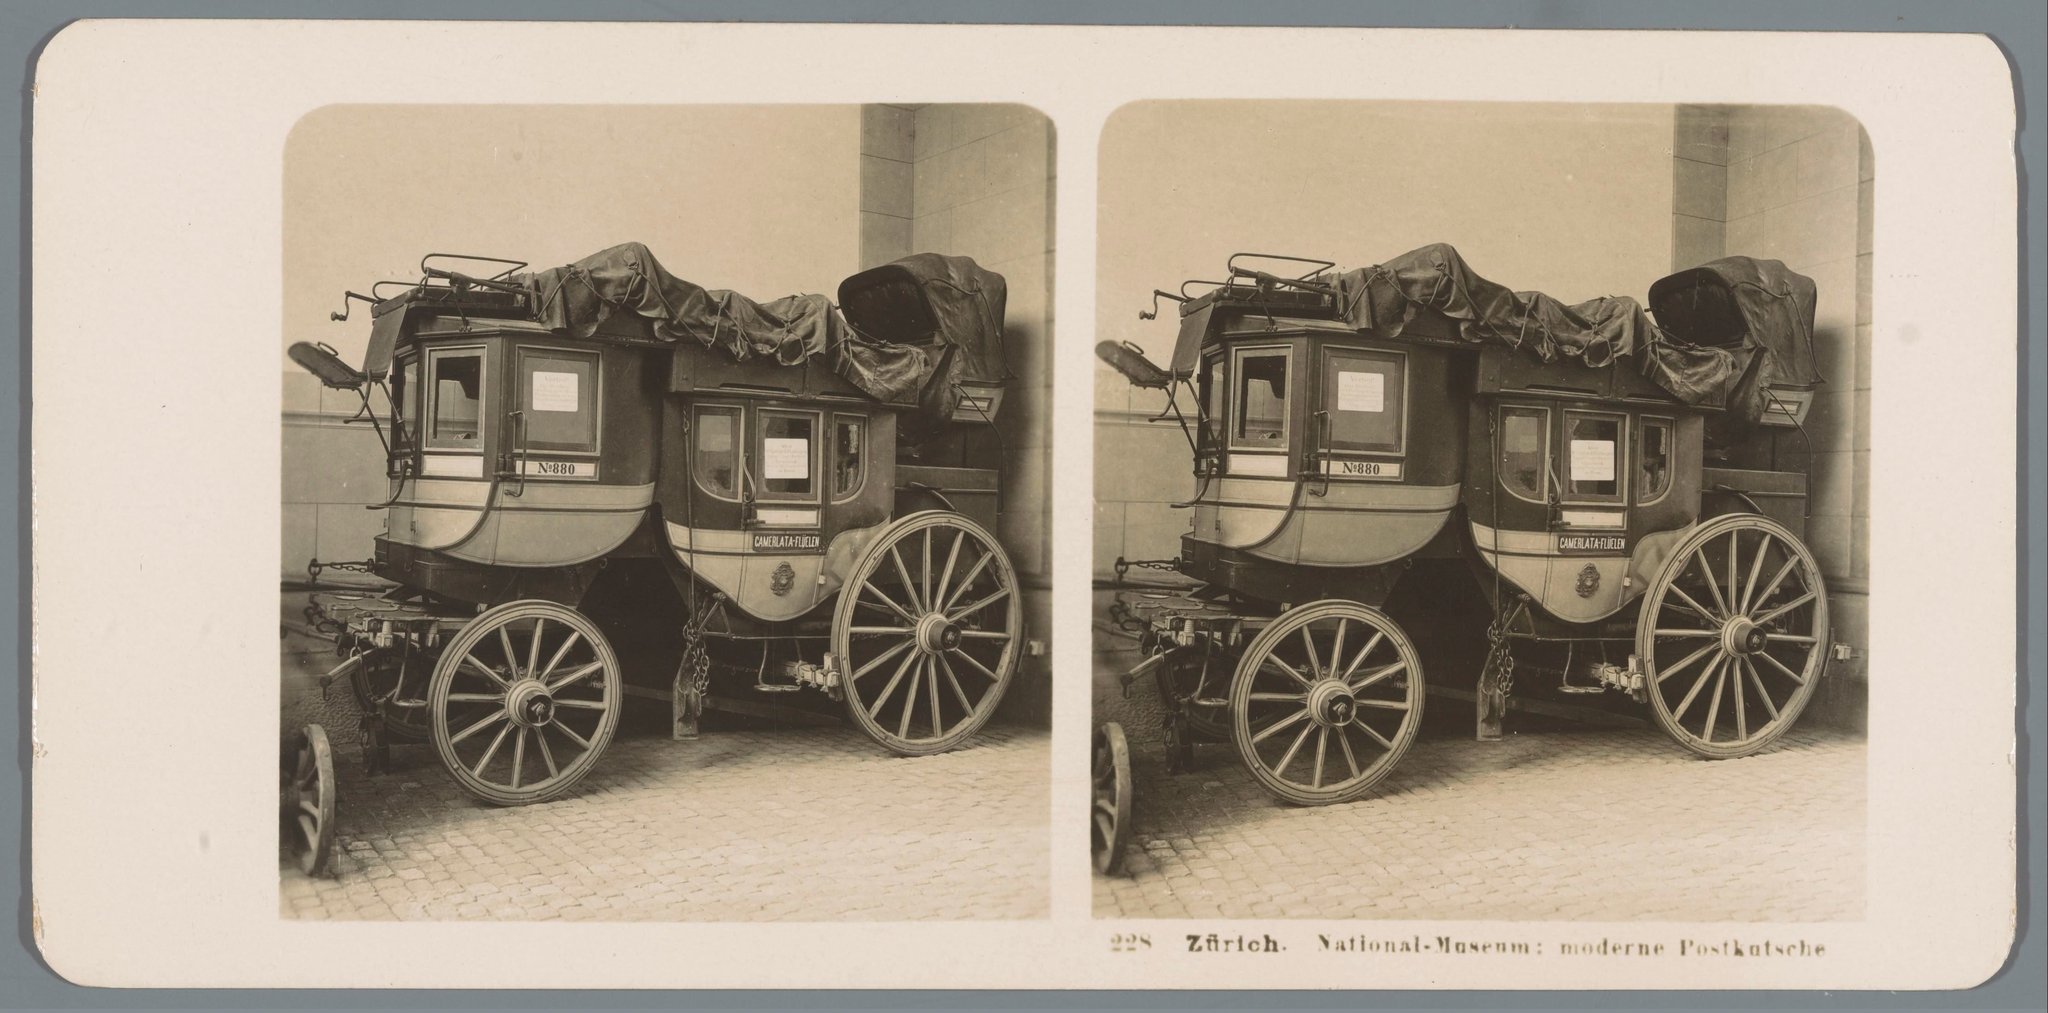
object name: stereograph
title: Postkoets in het Landesmuseum te Zürich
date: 1906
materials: cardboard, photographic support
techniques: gelatin silver print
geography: landesmuseum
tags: stage (~ mail-coach), permanent exhibition, museum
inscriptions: inscription: ‘Neue Photographische Gesellschaft A. G., Steglitz-Berlin. 1906.’, number: ‘228’